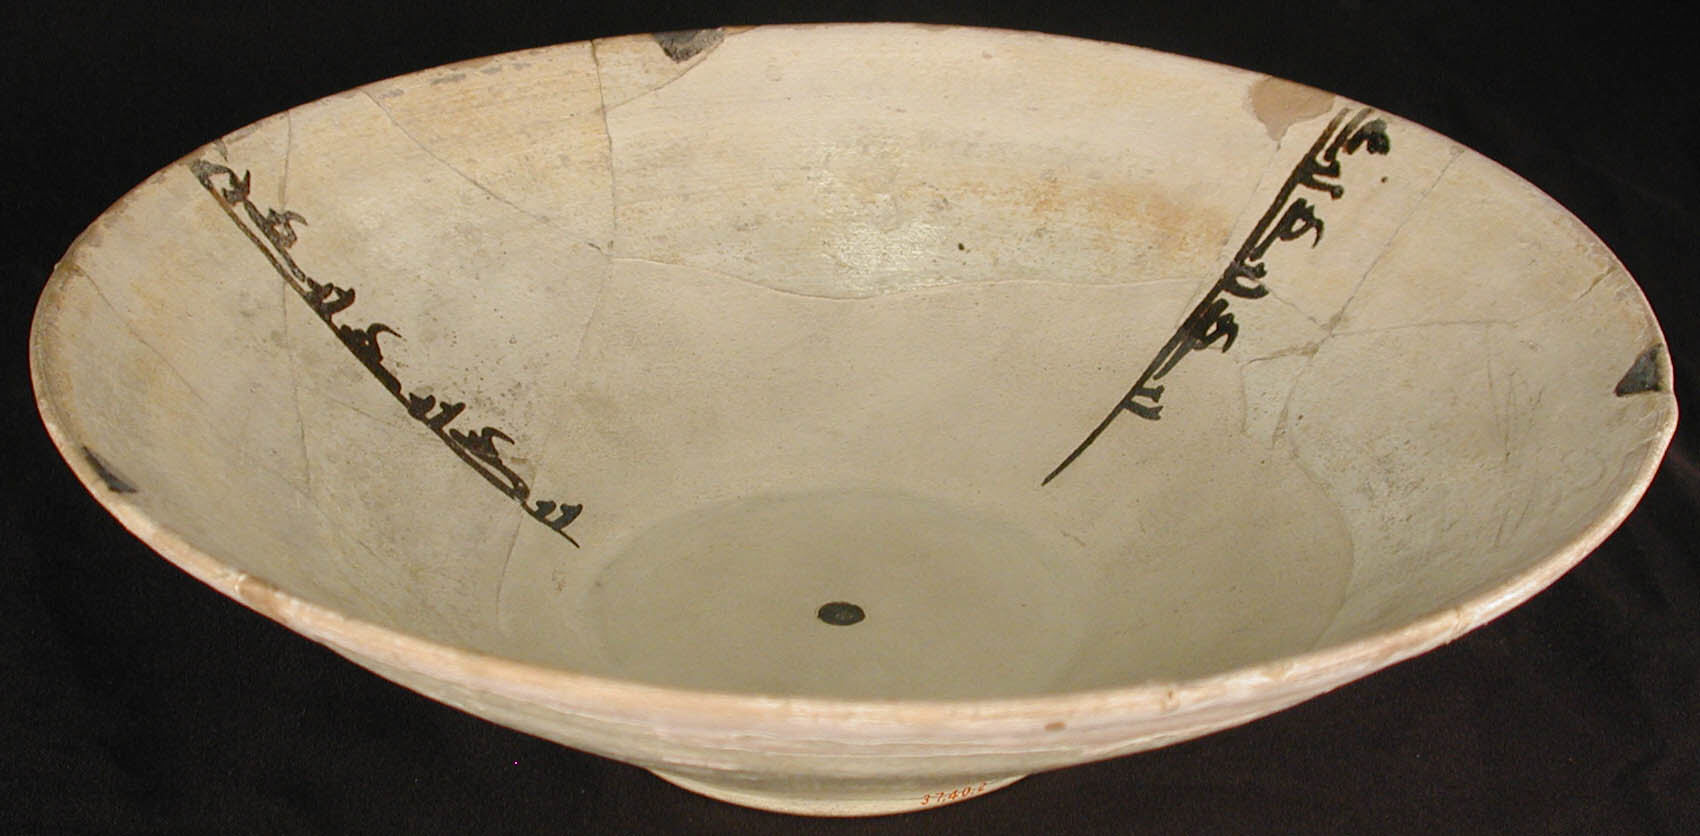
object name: bowl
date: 801-900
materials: earthenware, glaze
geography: iran